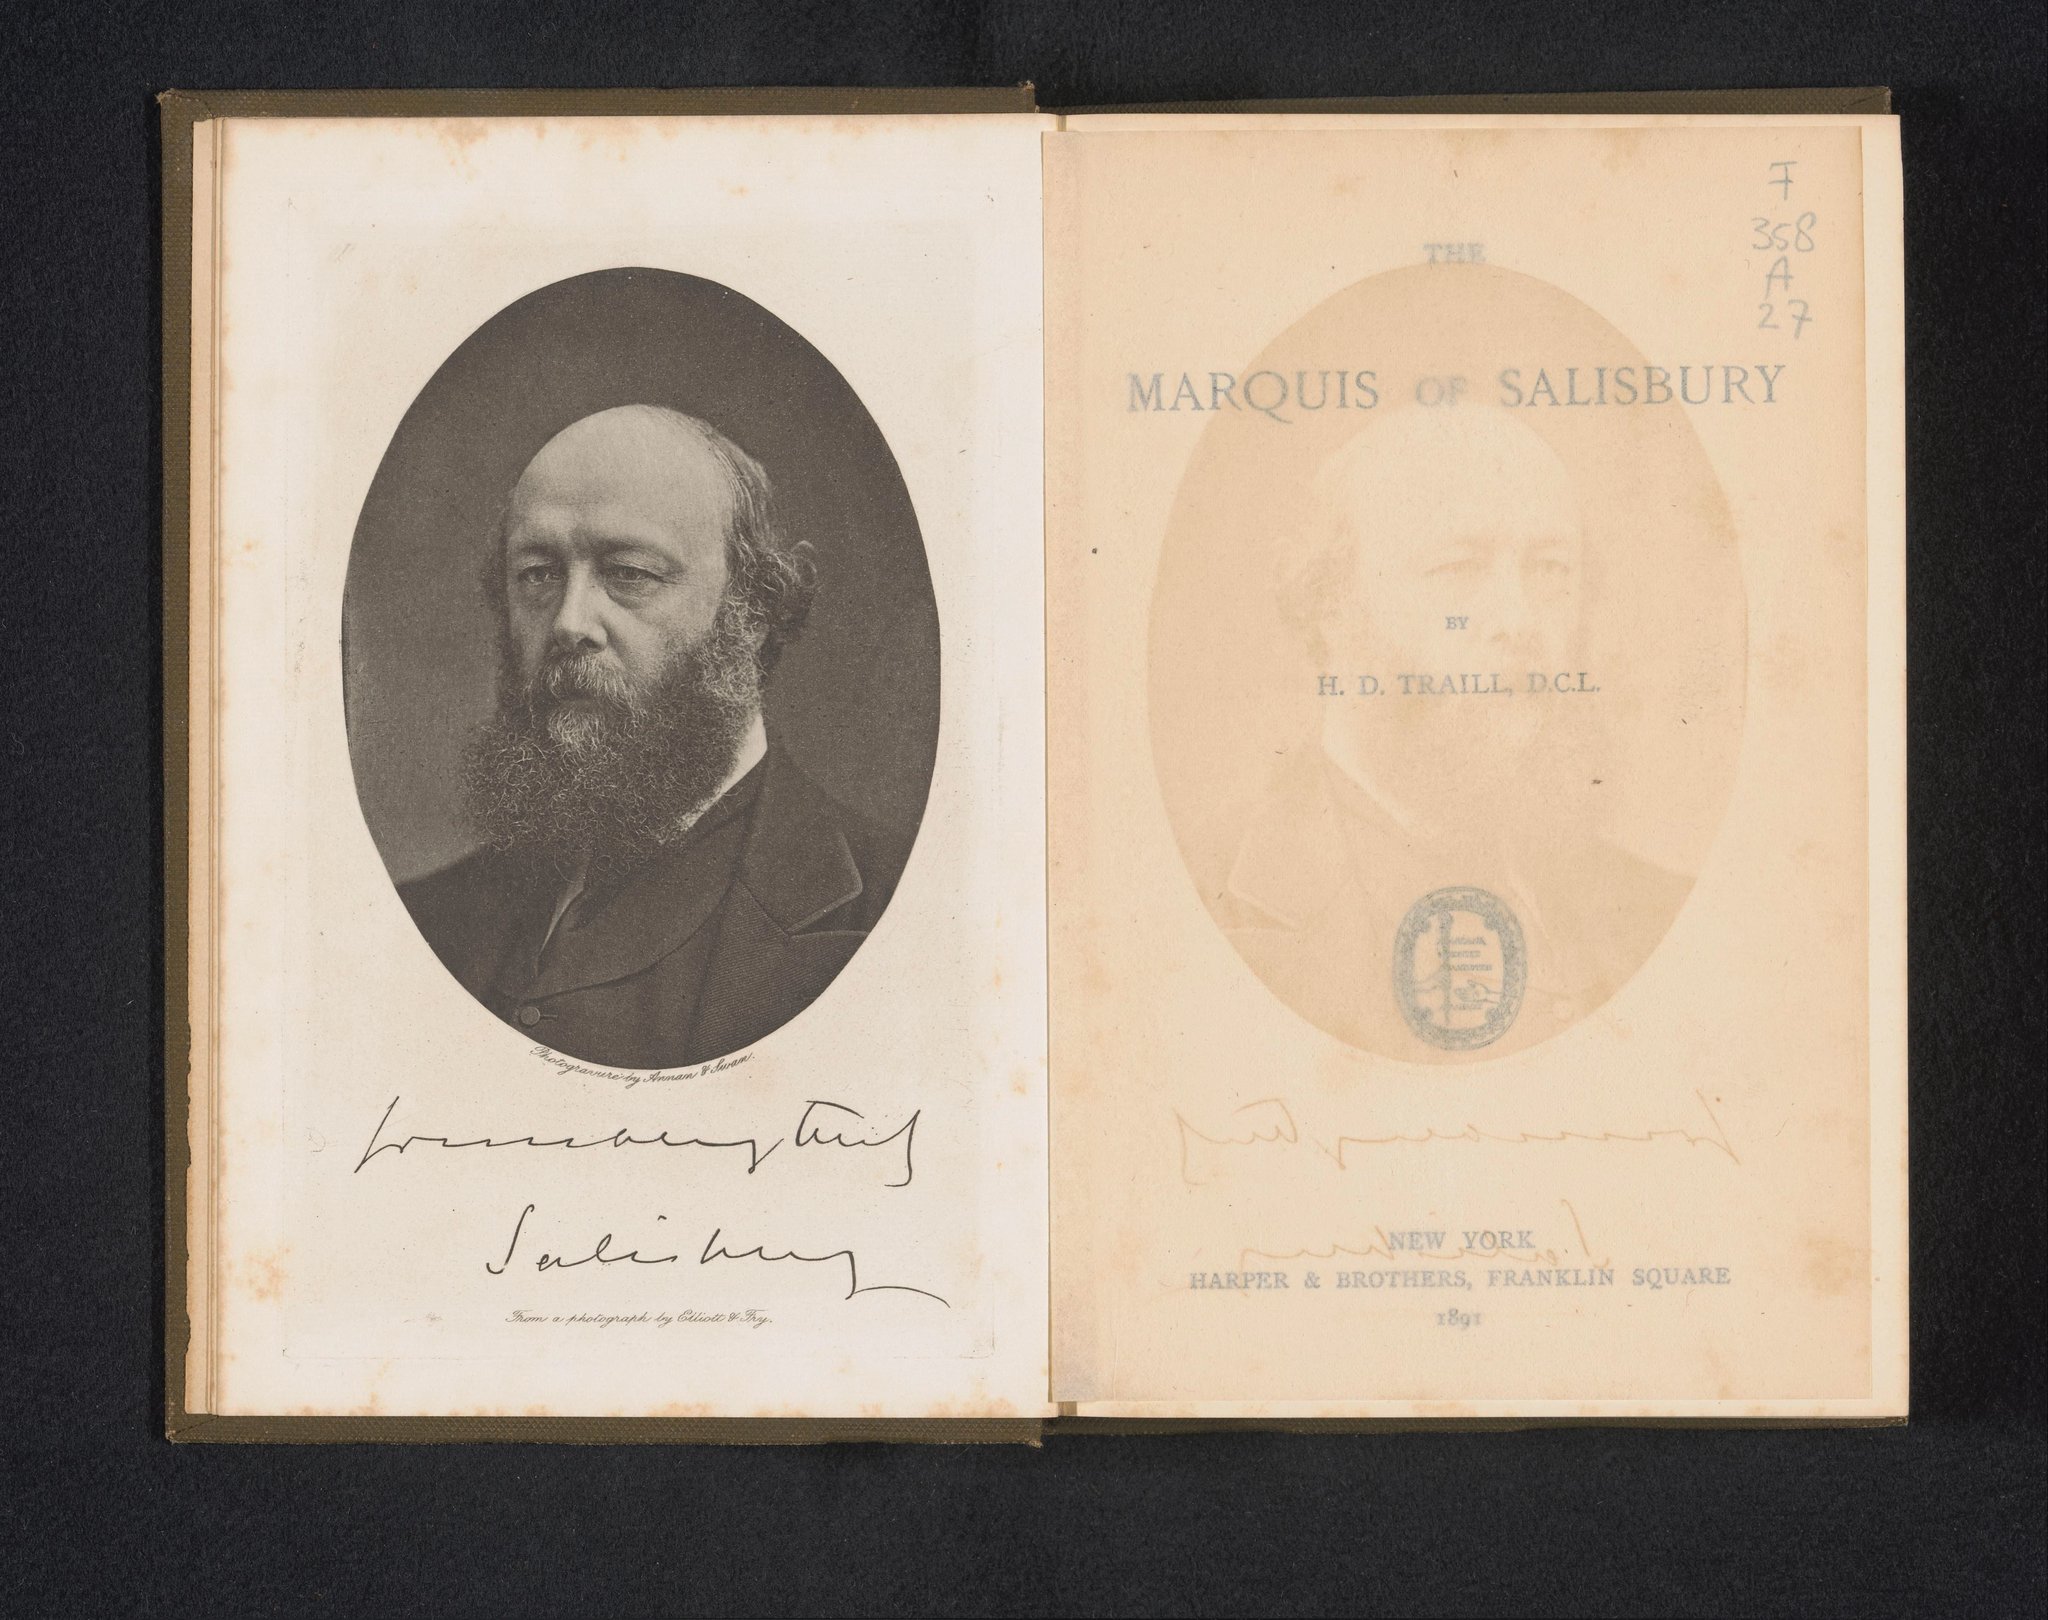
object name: page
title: Portret van Robert Arthur Talbot Gascoyne-Cecil, derde markies van Salisbury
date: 1886-1891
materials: paper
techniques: photoaquatint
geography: glasgow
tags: historical persons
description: Prent op titelpagina, achter semi-transparante omslag.